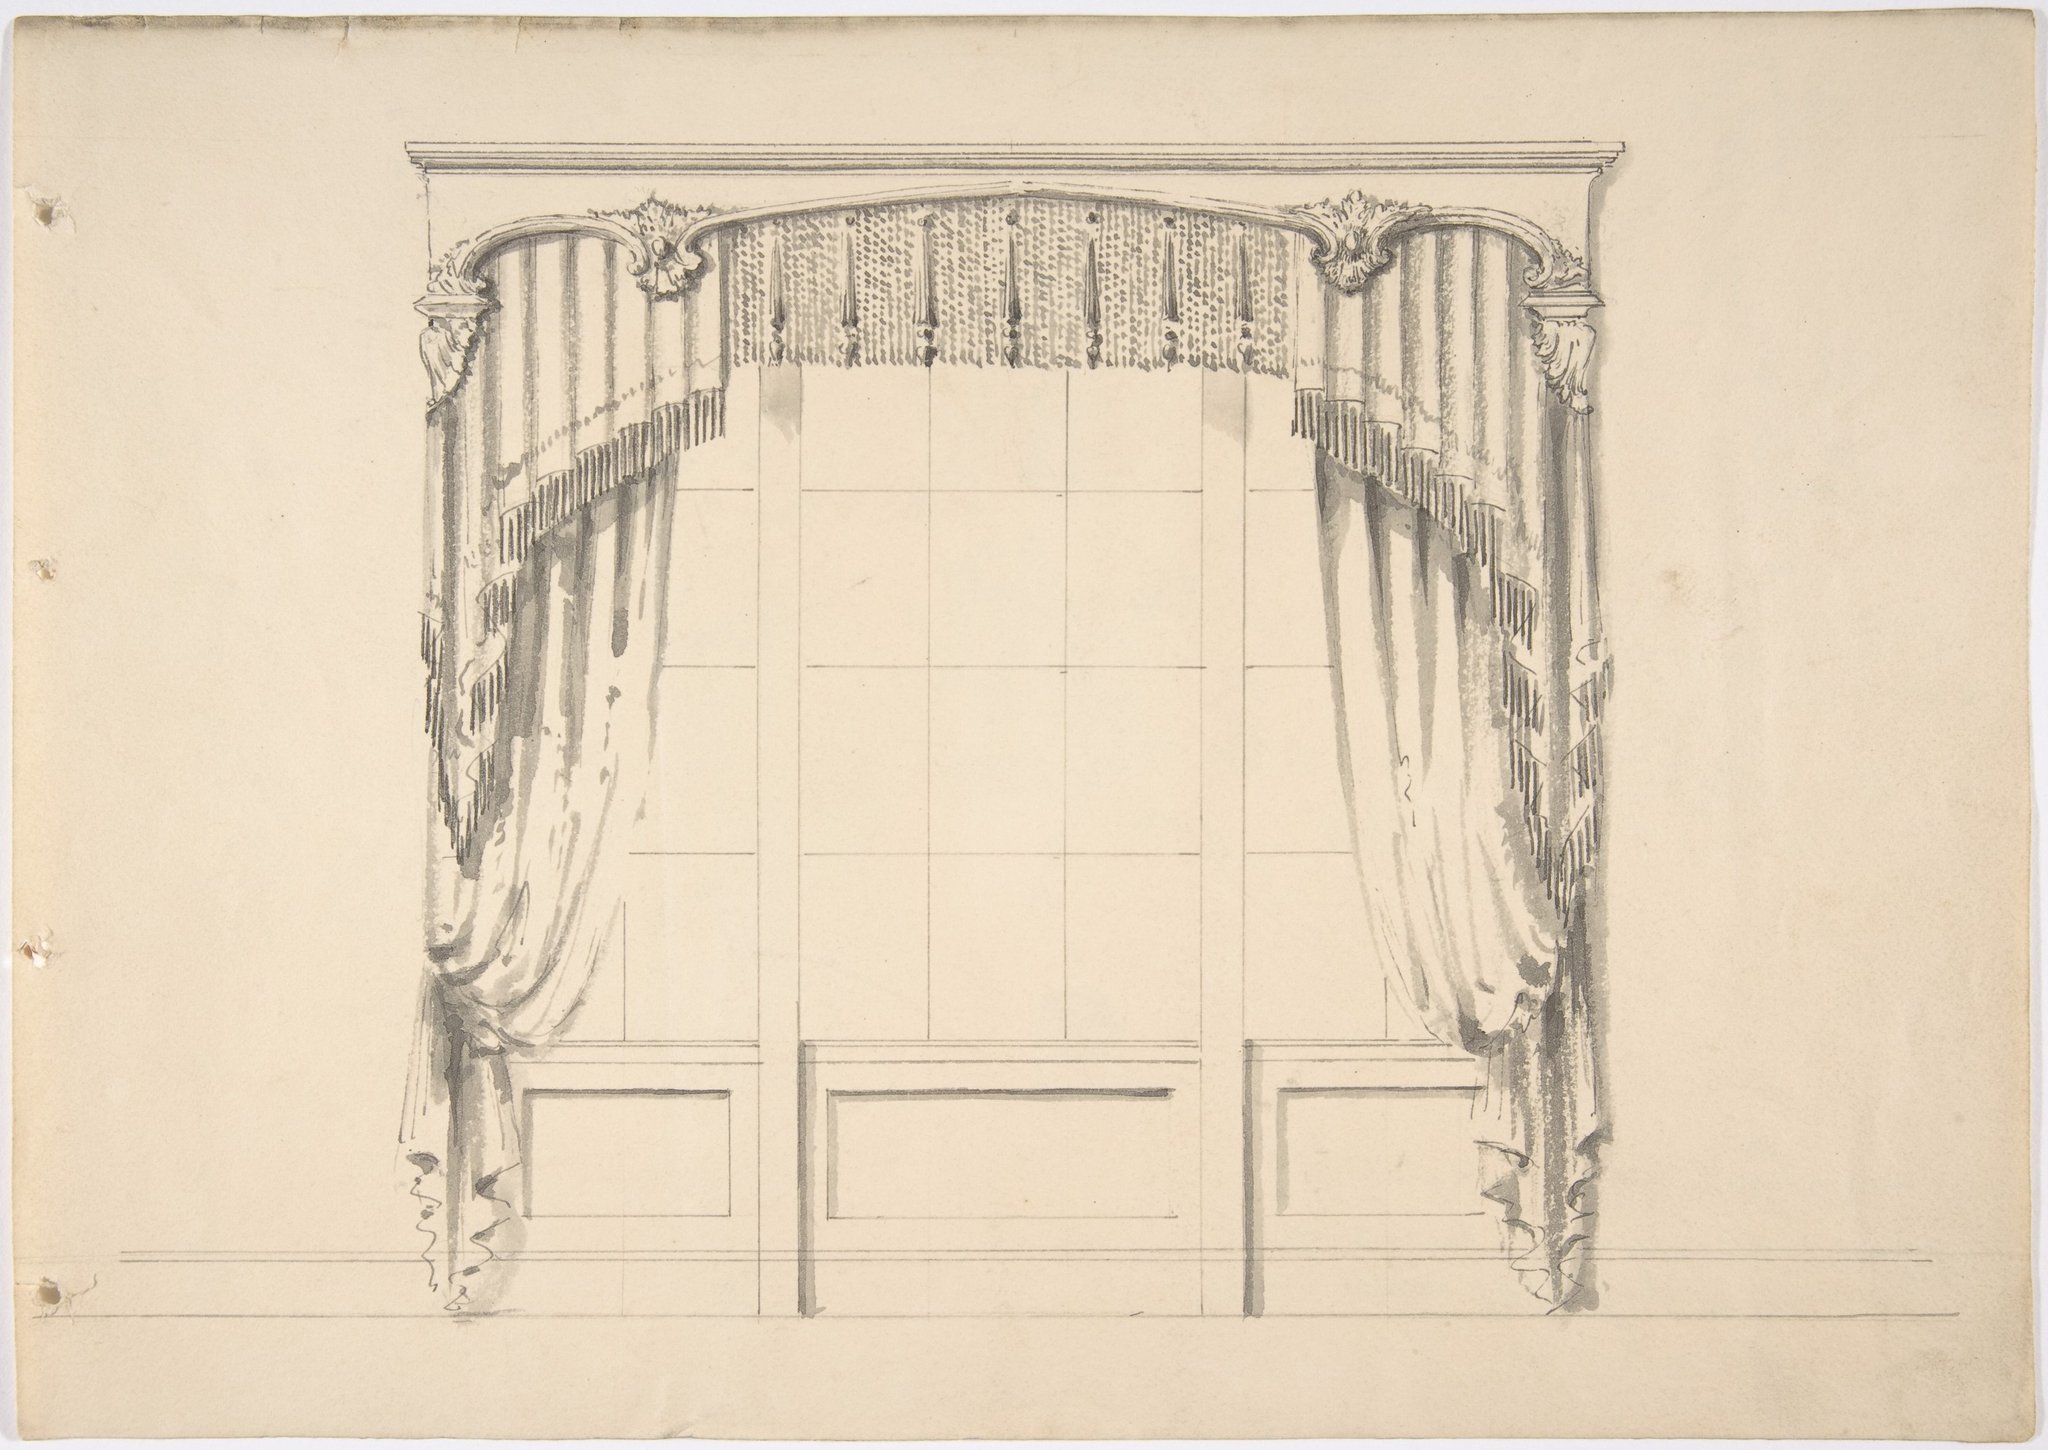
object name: drawing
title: Design for Fringed Curtains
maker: anonymous, british, 19th century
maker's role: artist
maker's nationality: british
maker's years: 1800-1900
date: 1801-1833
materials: ink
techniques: brush, pen, wash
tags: windows,curtains